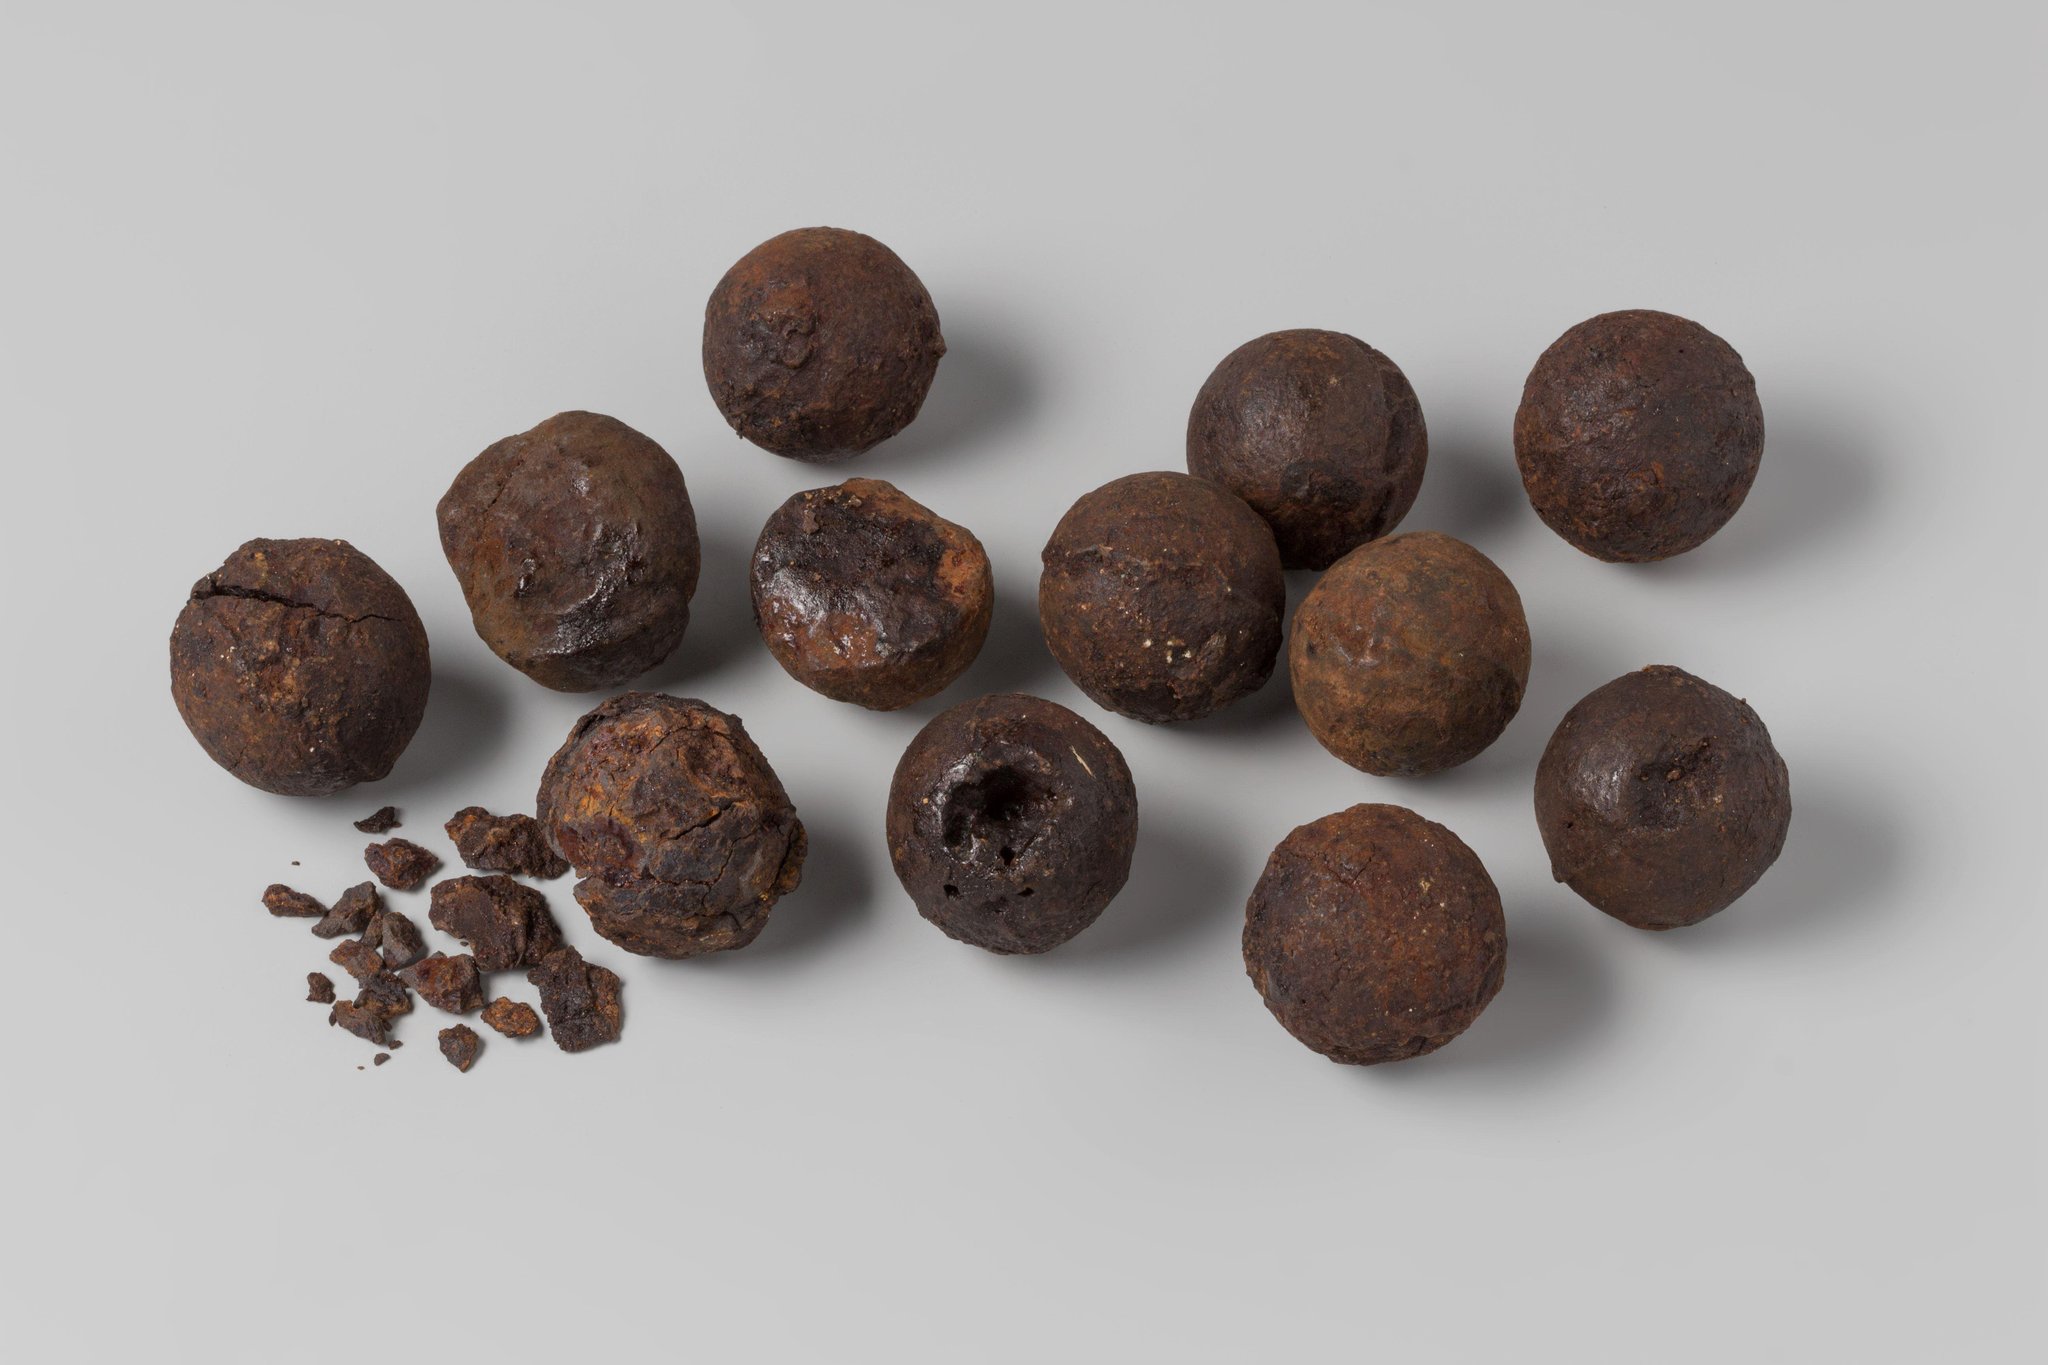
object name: bullet ammunition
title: Kogels uit het wrak van de Oost-Indiëvaarder Hollandia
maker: Anonymous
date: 1700-1743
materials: iron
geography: netherlands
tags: verenigde oostindische compagnie, hollandia (schip), annet